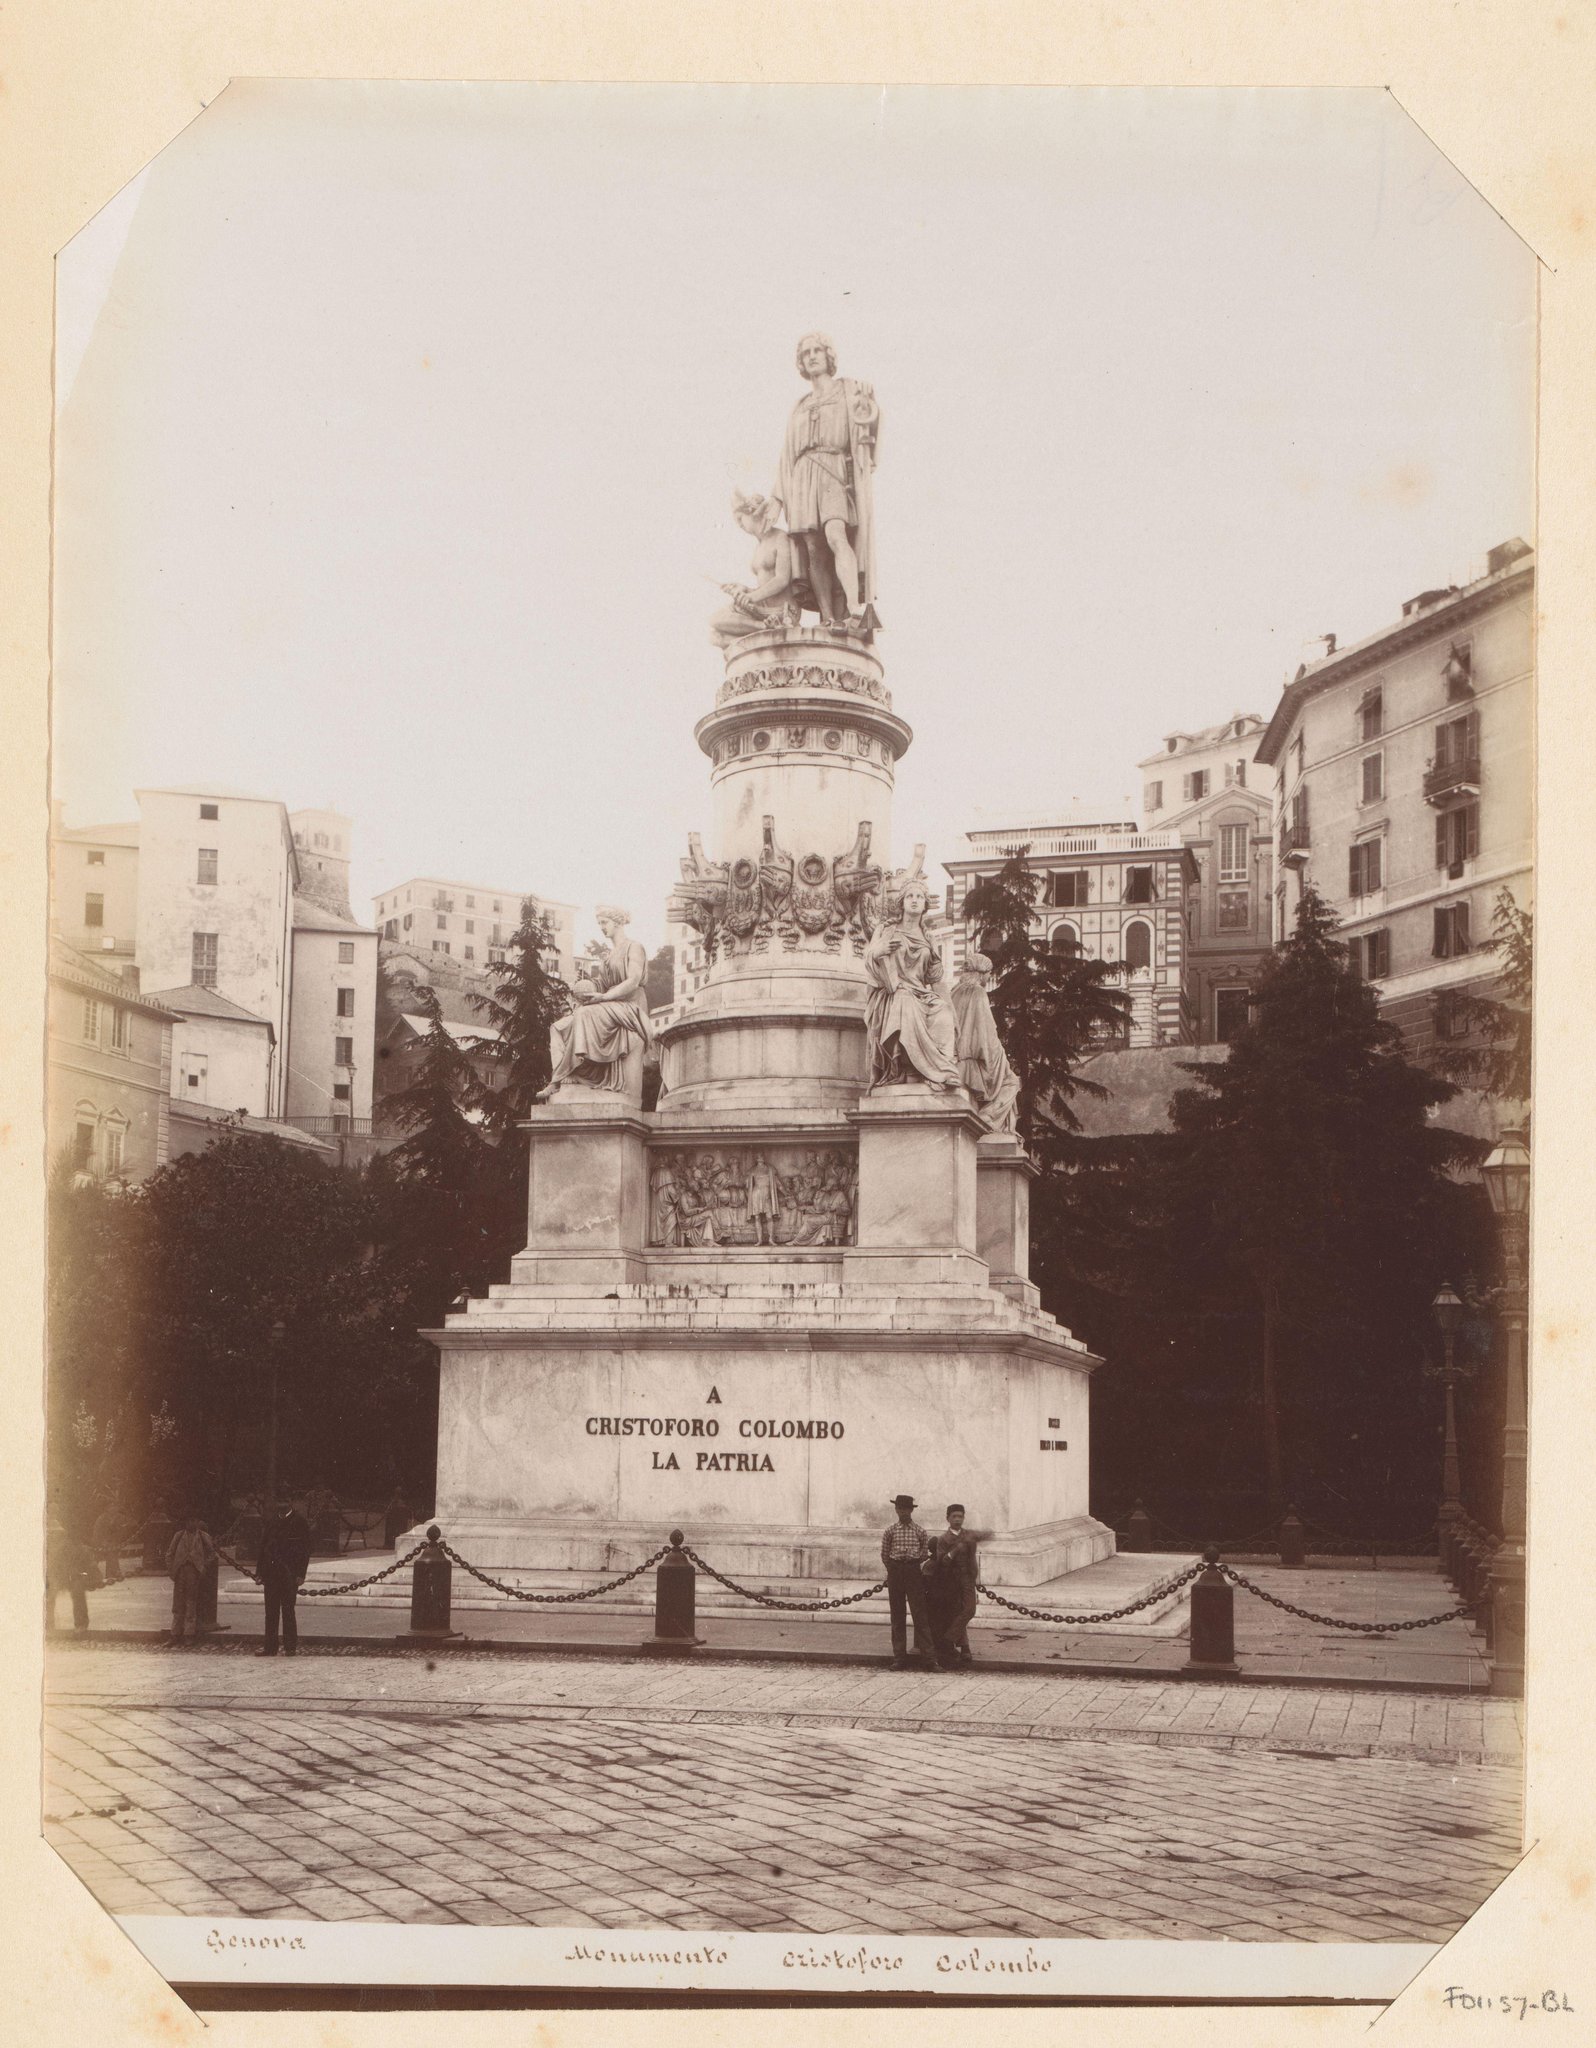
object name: album leaf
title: Monument voor Christoffel Columbus te Genua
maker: Anonymous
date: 1885-1892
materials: photographic support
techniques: albumen print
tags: monument, statue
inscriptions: annotation: ‘Genua - Columbus monument’